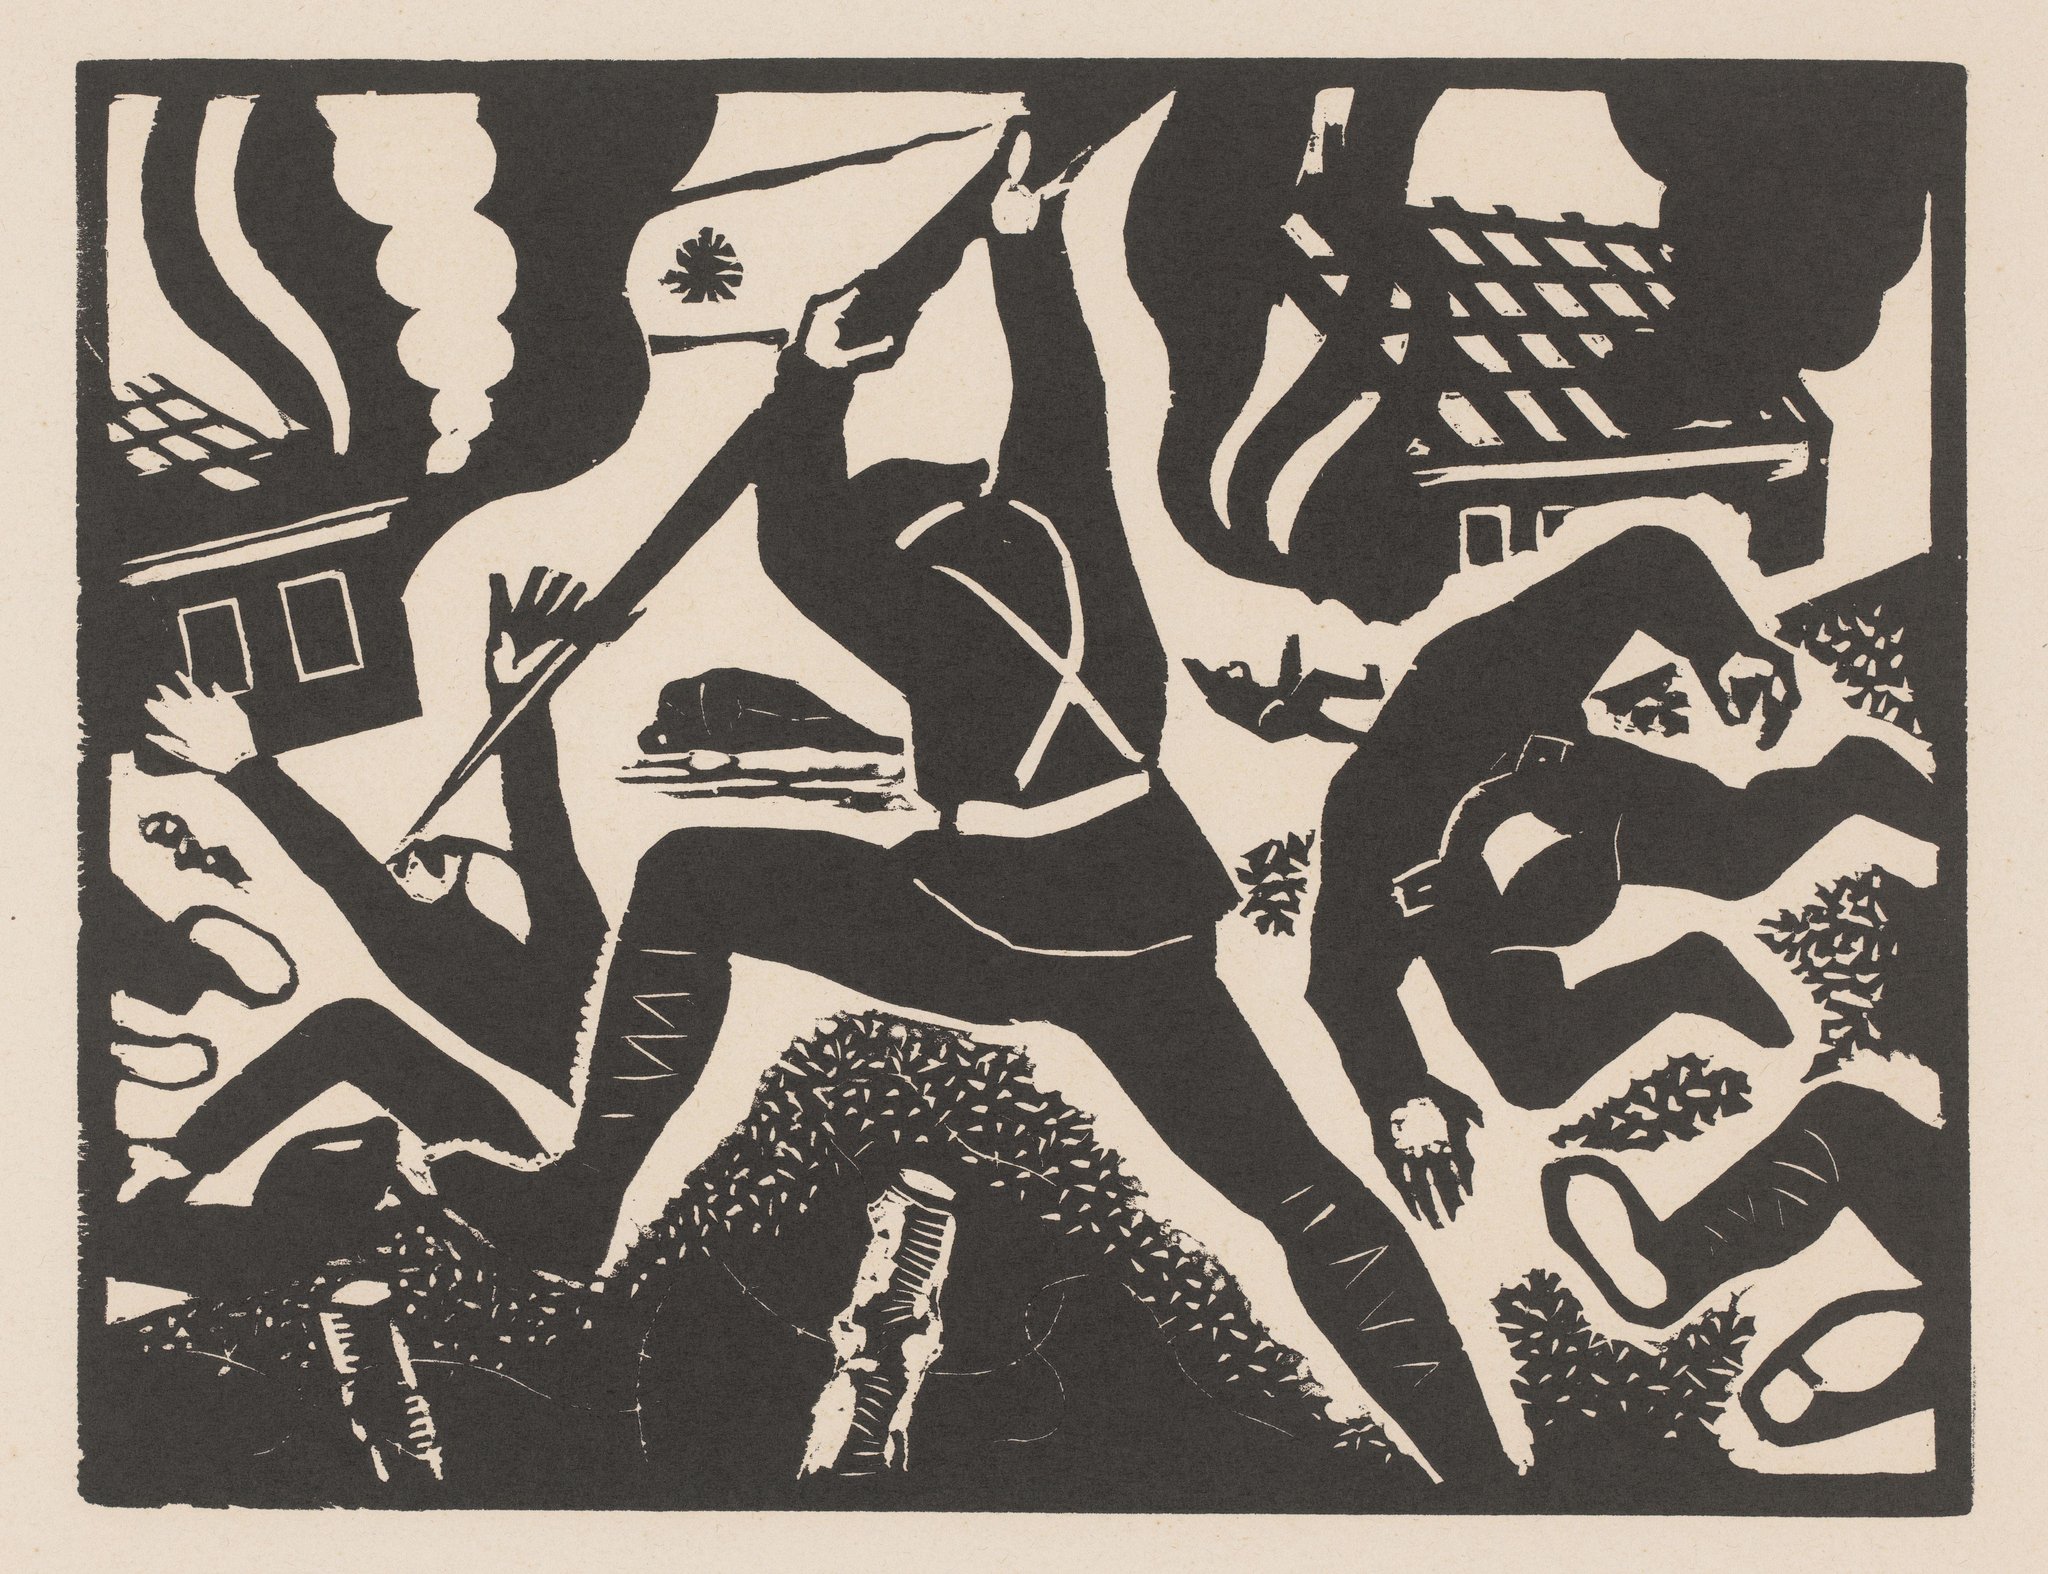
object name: print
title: Tegen oorlog en fascisme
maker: Anonymous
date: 1933-1935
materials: paper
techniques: woodcut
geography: amsterdam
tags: anti-militarism, pacifism, hand-to-hand fighting (~ battle)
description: Oorlogsgeweld. Een soldaat steekt met bajonet een op de grond liggende tegenstander dood. Omringd door gesneuvelde soldaten, op de achtergrond brandende huizen. Politieke prenten van ca. 1933-1935. Onderdeel van een serie van zes houtsneden uitgegeven in een groene kartonnen omslag onder de titel: Tegen oorlog en fascisme.